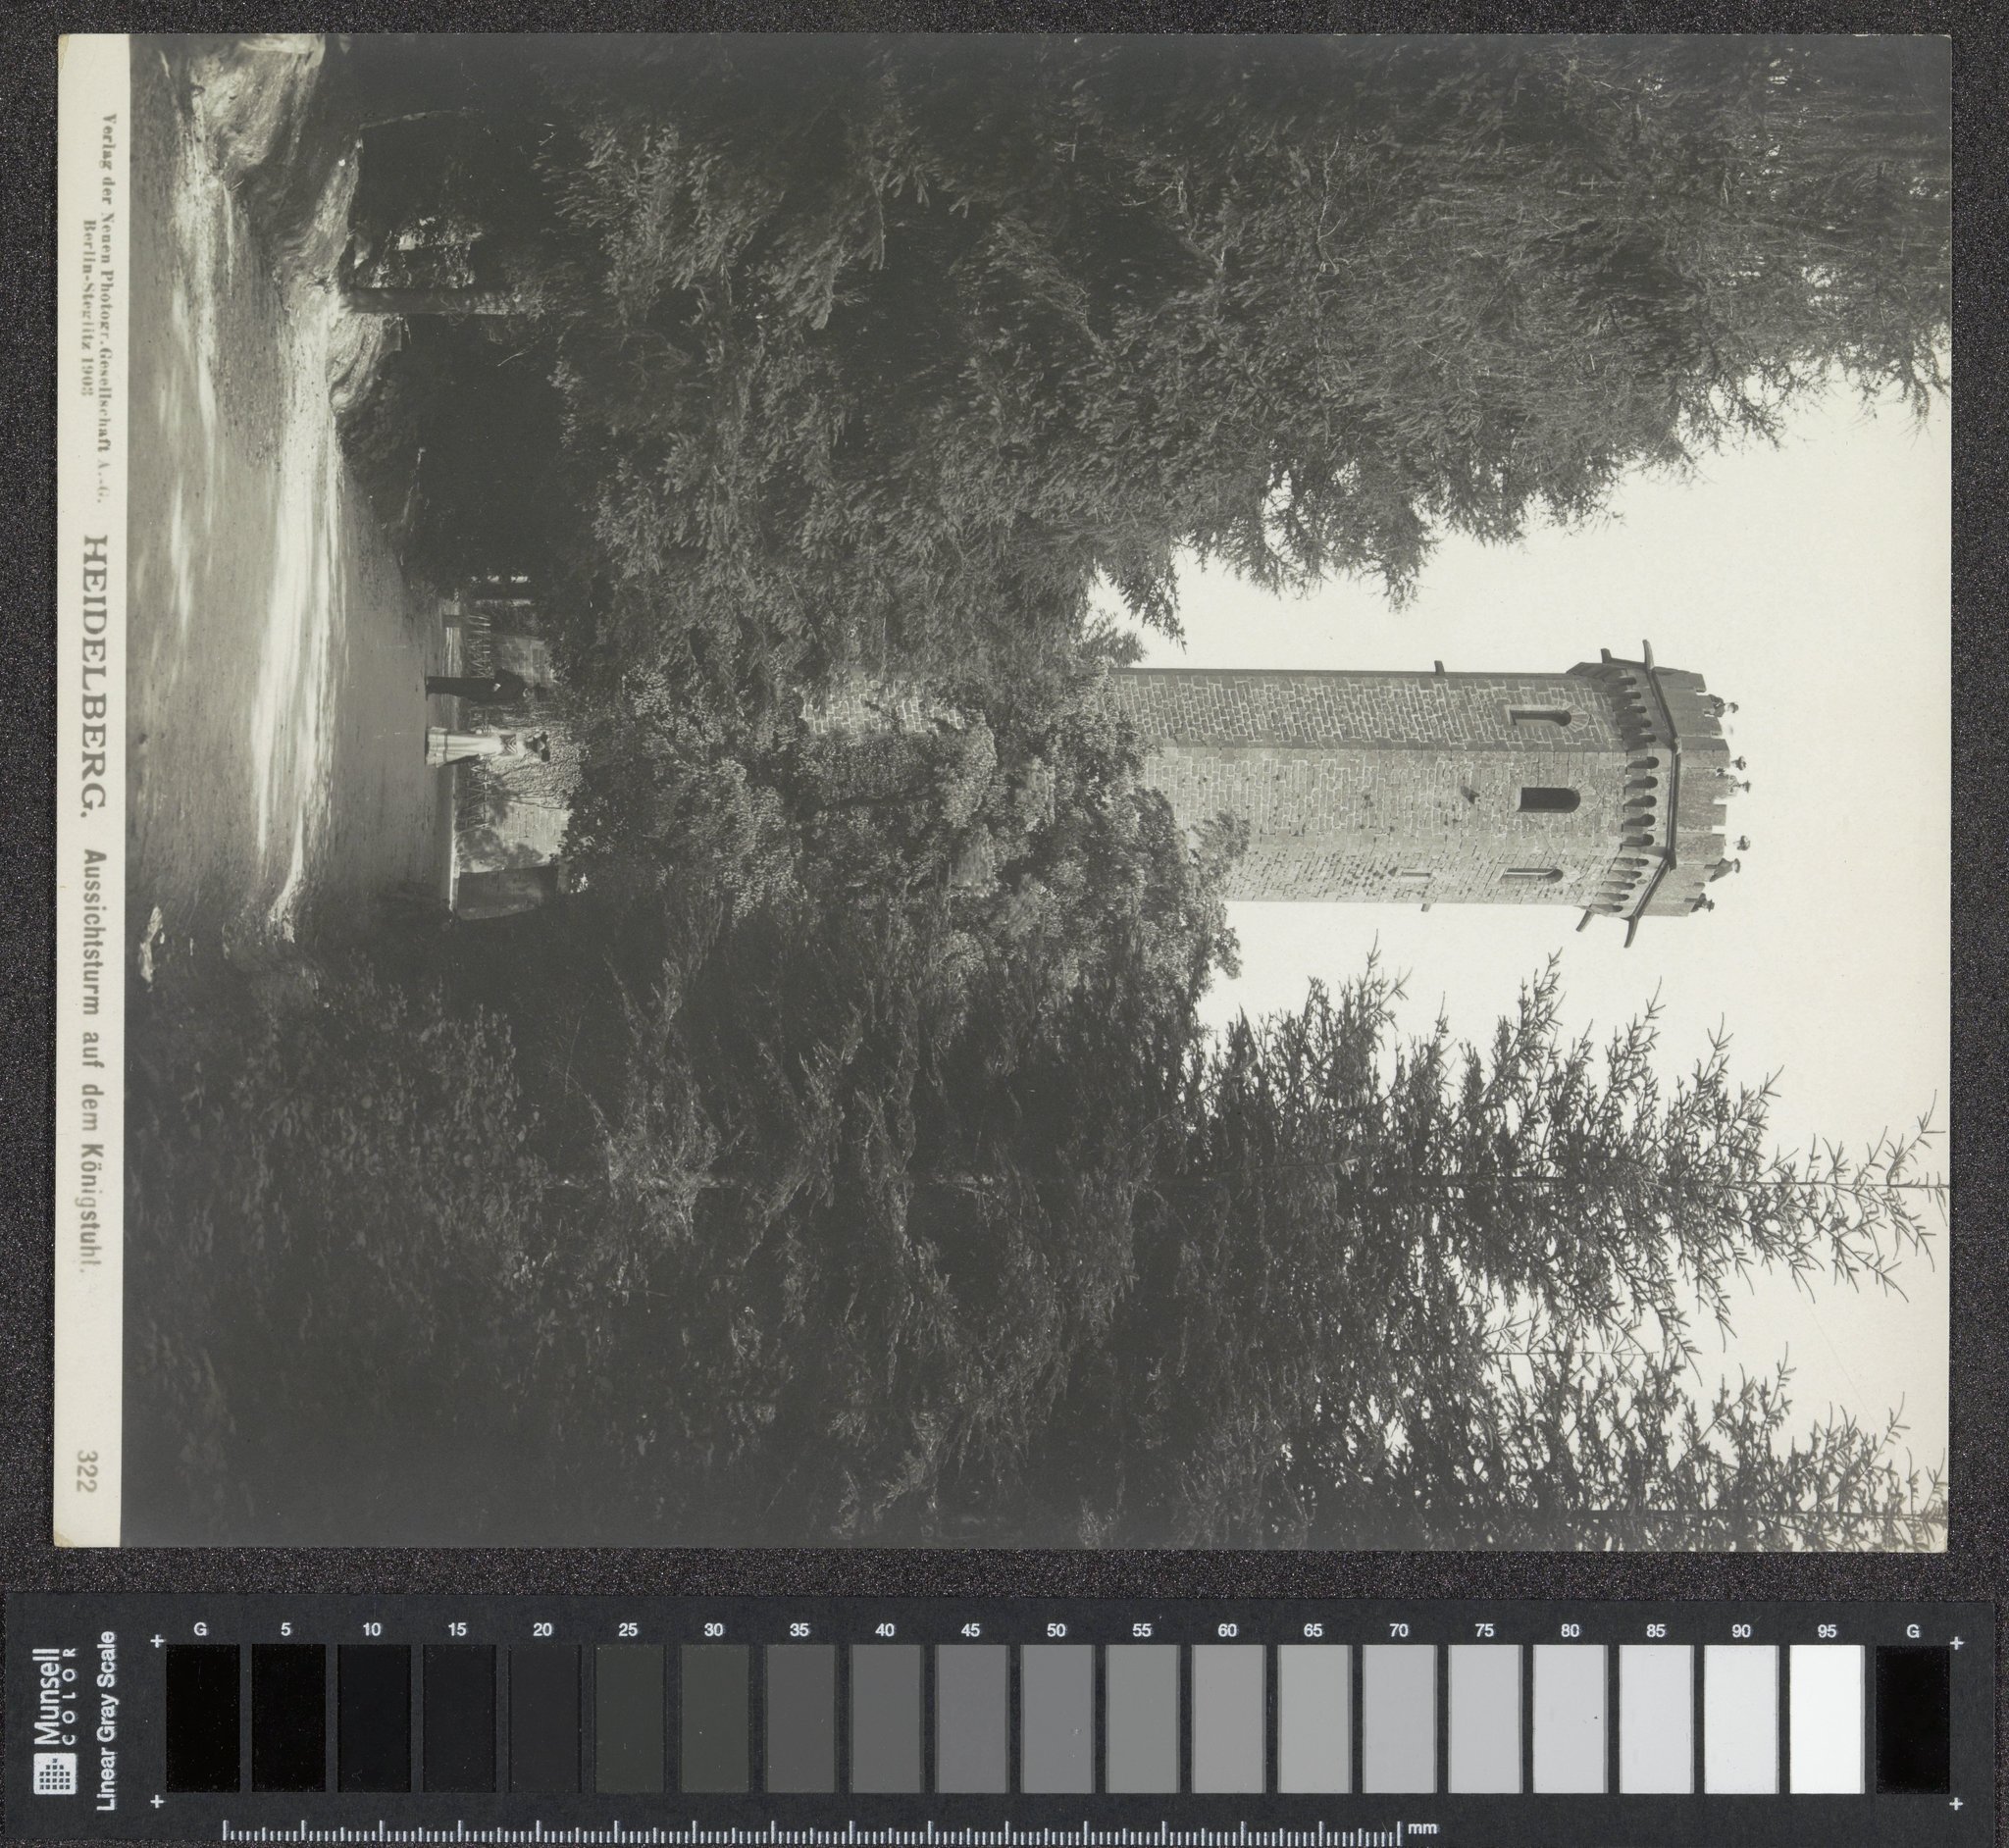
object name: photograph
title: Heidelberg. Aussichtturm auf dem Königstuhl.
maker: Anonymous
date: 1903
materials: photographic support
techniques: gelatin silver print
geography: heidelberg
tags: landscape with tower or castle, prospect of city, town panorama, silhouette of city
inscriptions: number: ‘322’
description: Onderdeel van Fotoalbum met opnames van Heidelberg en Schloss Heidelberg.